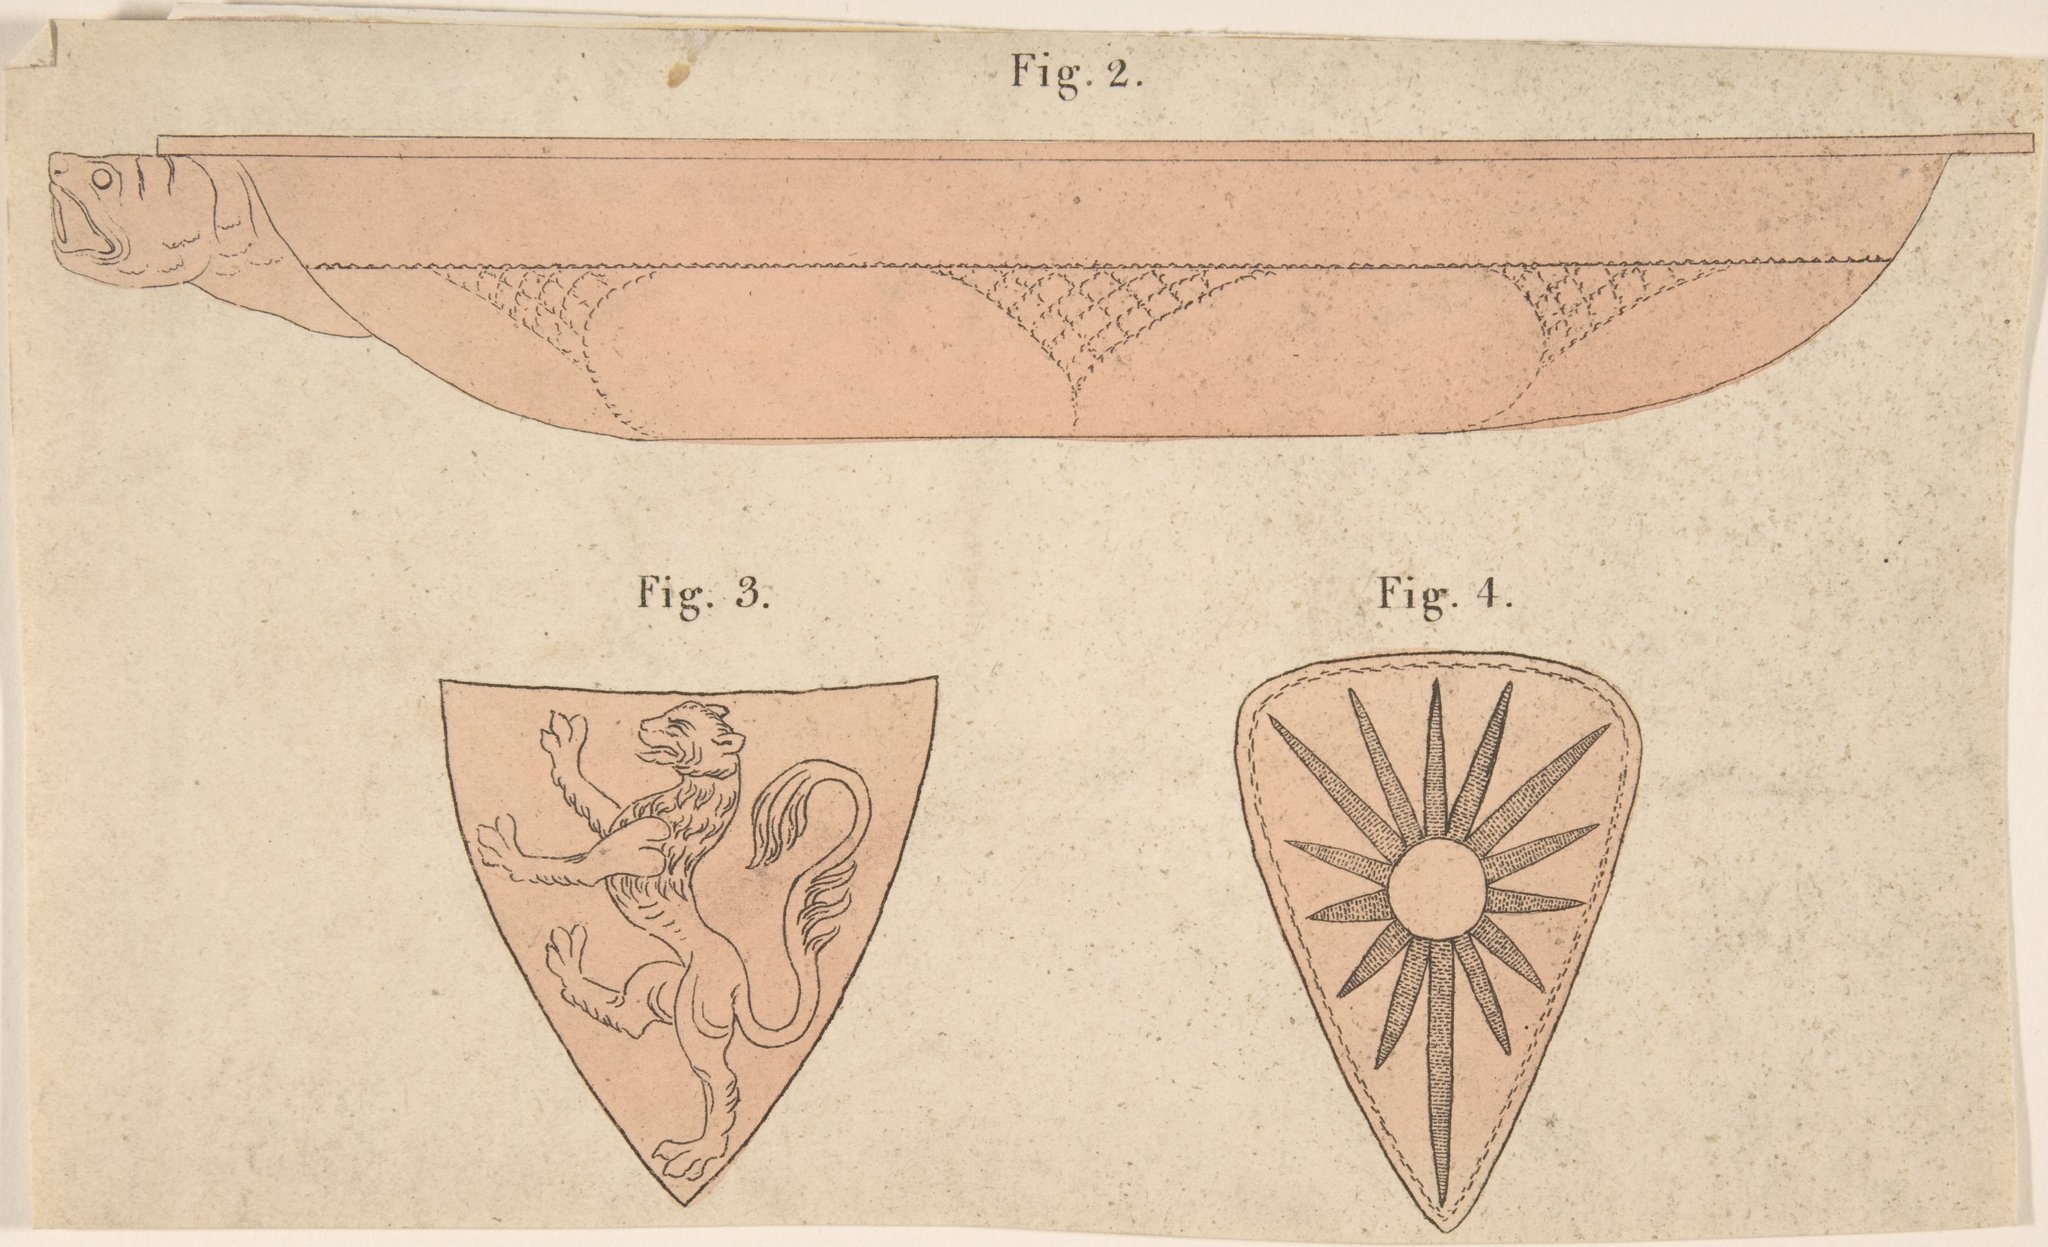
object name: drawing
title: Shield Designs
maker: anonymous, british, 19th century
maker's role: artist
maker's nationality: british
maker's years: 1800-1900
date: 1851-1900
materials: ink, watercolor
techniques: pen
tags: shields,lions,turtles